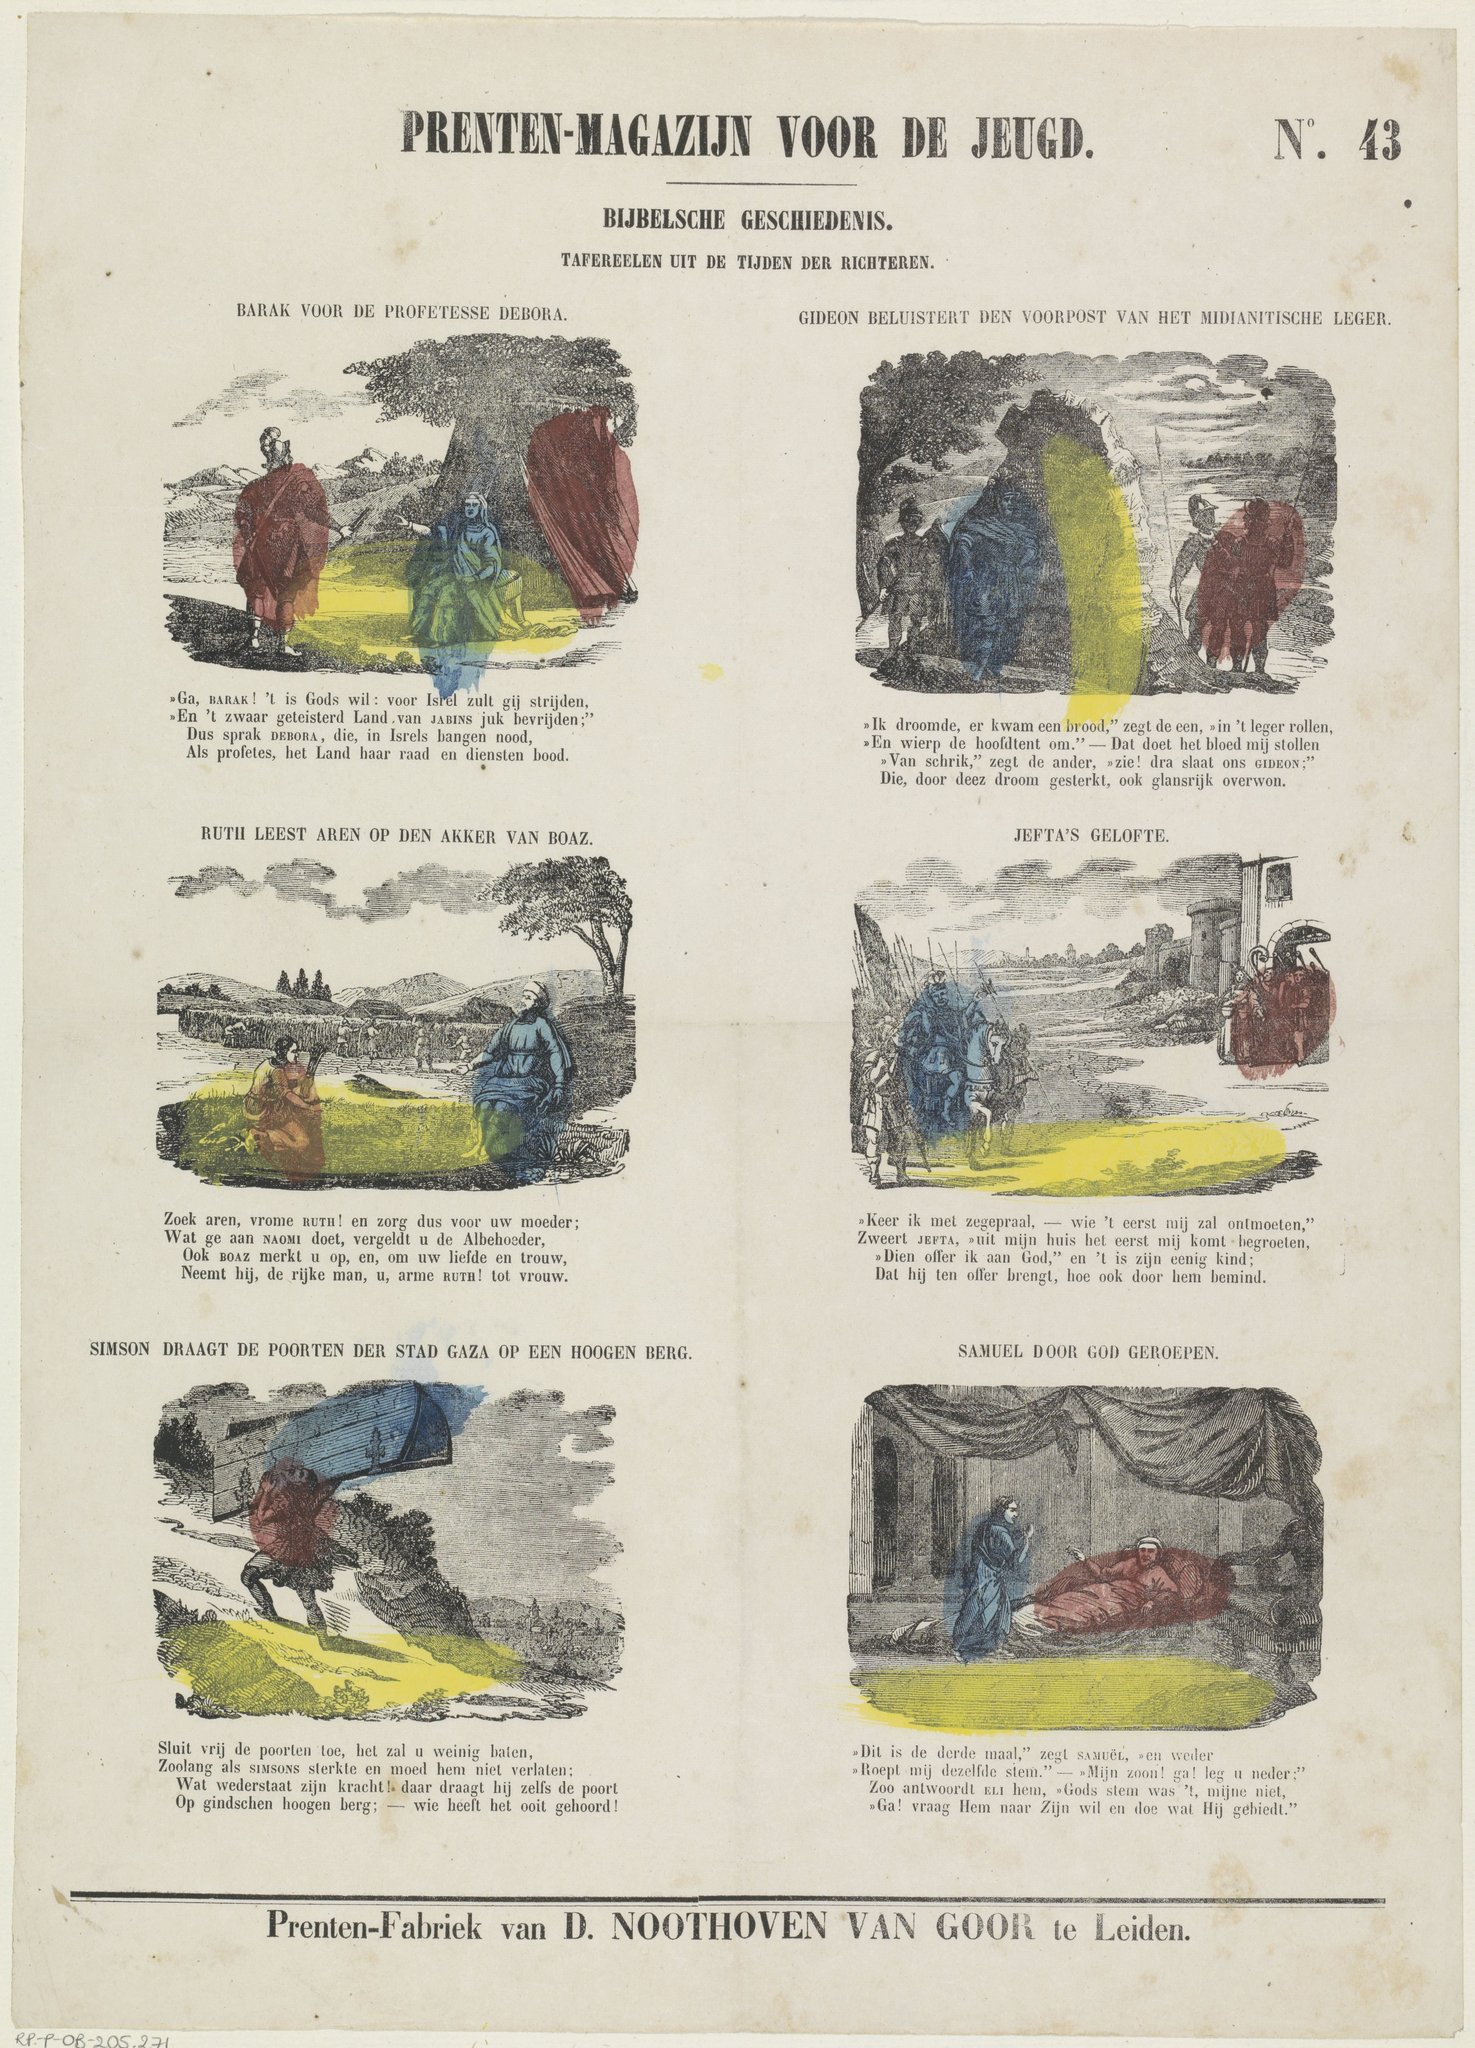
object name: popular print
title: Tafereelen uit de tijden der richteren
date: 1850-1881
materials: paper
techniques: colour, letterpress printing, engraving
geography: netherlands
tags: the time of the judges, old testament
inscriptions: collector's mark: Lugt 2760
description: Blad met 6 voorstellingen van verhalen uit het Oude Testament. Boven elke voorstelling een titel en onder elke voorstelling een vierregelig vers. Genummerd rechtsboven: No. 43.